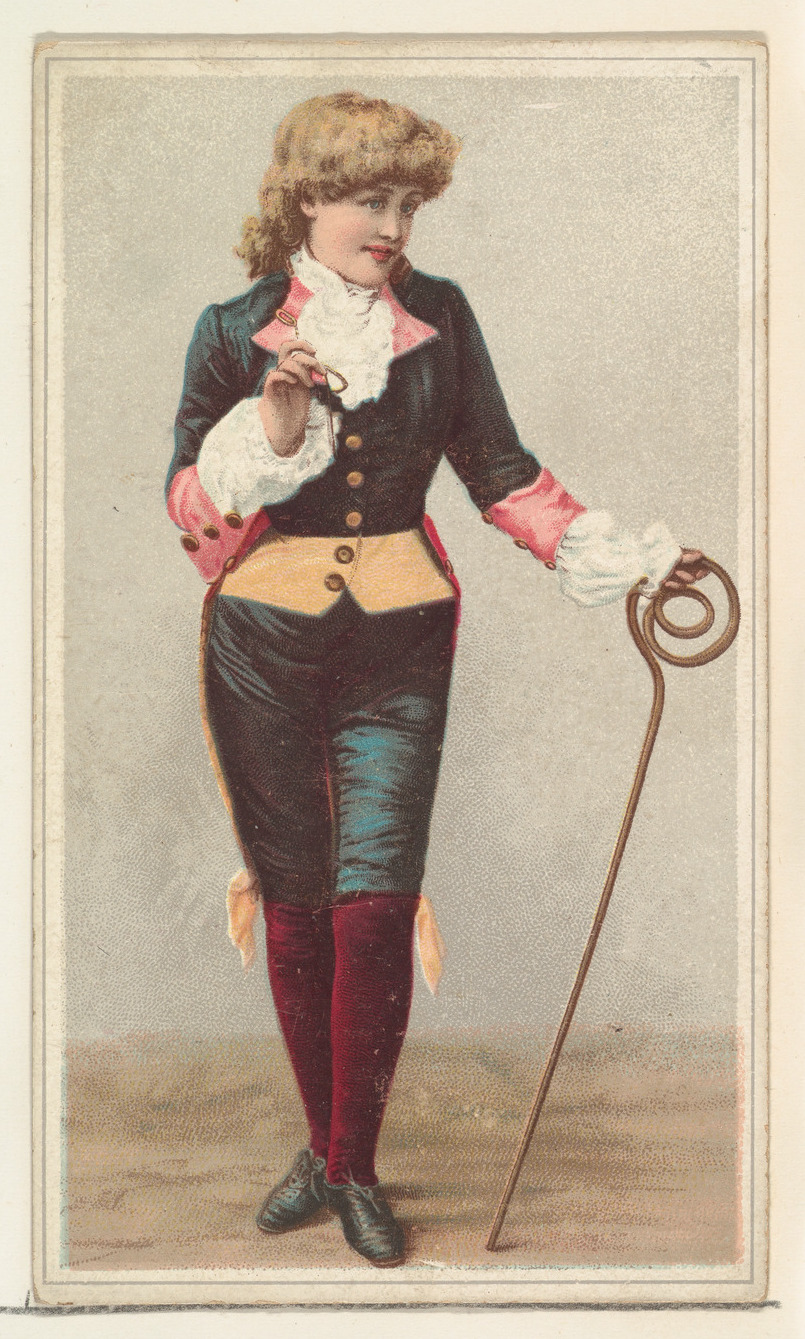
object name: print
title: Actress wearing costume with elaborate cane, from Stars of the Stage, Second Series (N130) issued by Duke Sons & Co. to promote Honest Long Cut Tobacco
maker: w. duke, sons & co.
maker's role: publisher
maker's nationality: american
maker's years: 1870-1920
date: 1891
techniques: color lithograph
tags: women,actresses